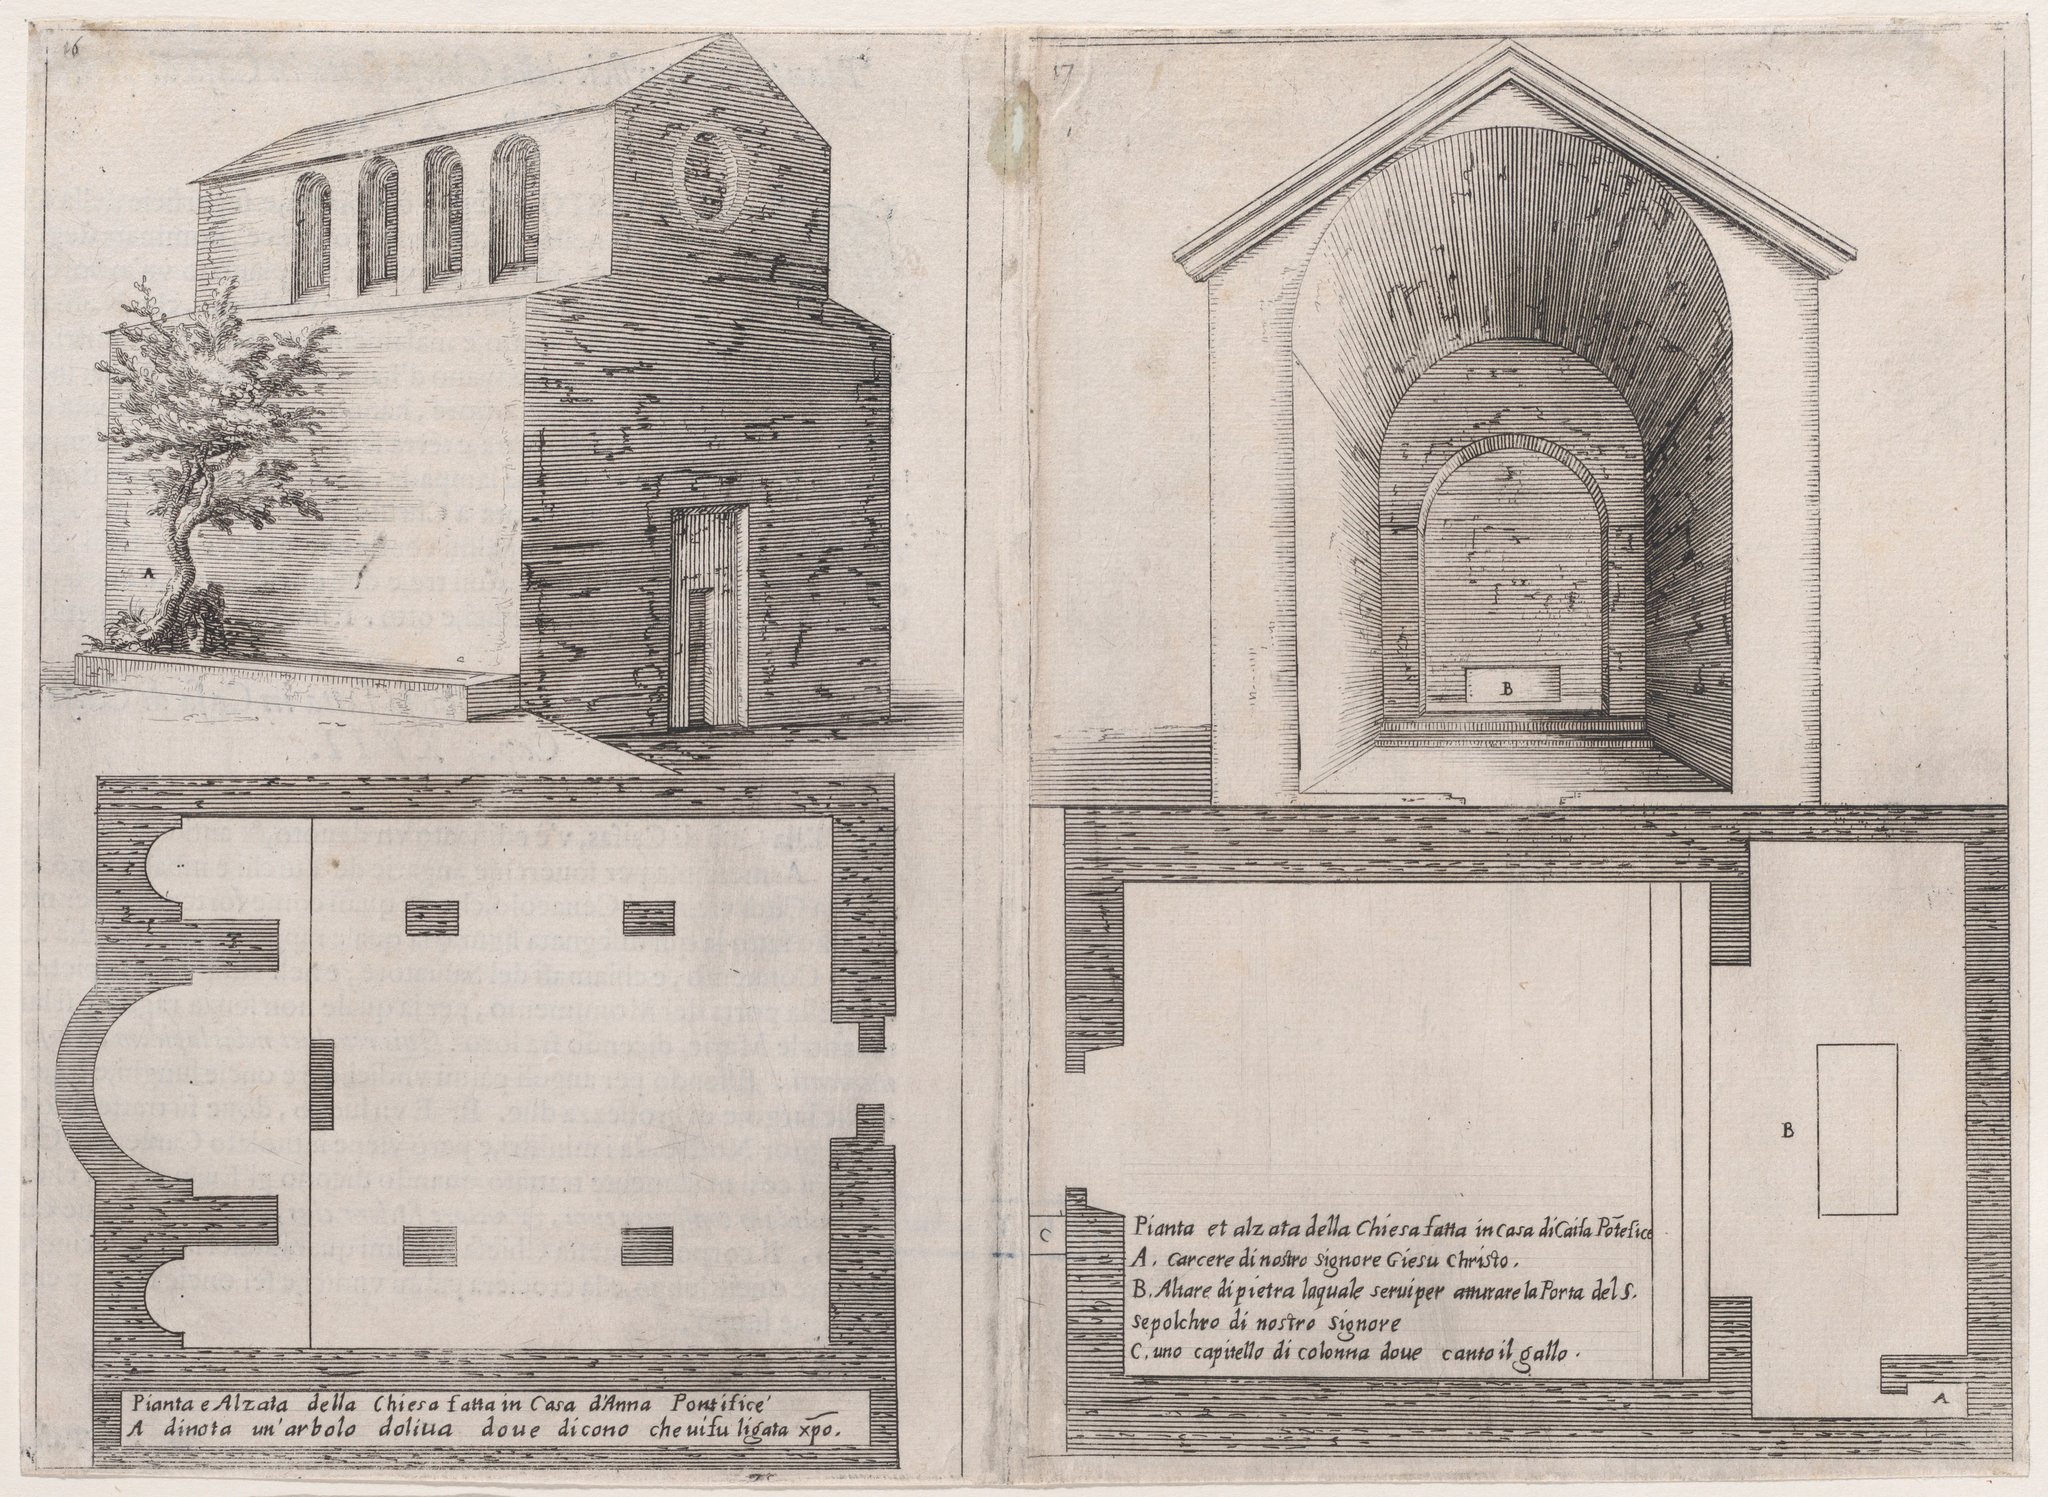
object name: print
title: Plates 12 and 13, from "Trattato delle Piante & Immagini de Sacri Edifizi di Terra Santa" (Treatise of the Plans & Images of the Sacred Buildings of the Holy Land)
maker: jacques callot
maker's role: artist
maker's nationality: french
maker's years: 1592-1635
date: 1620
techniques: engraving, etching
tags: architecture,buildings